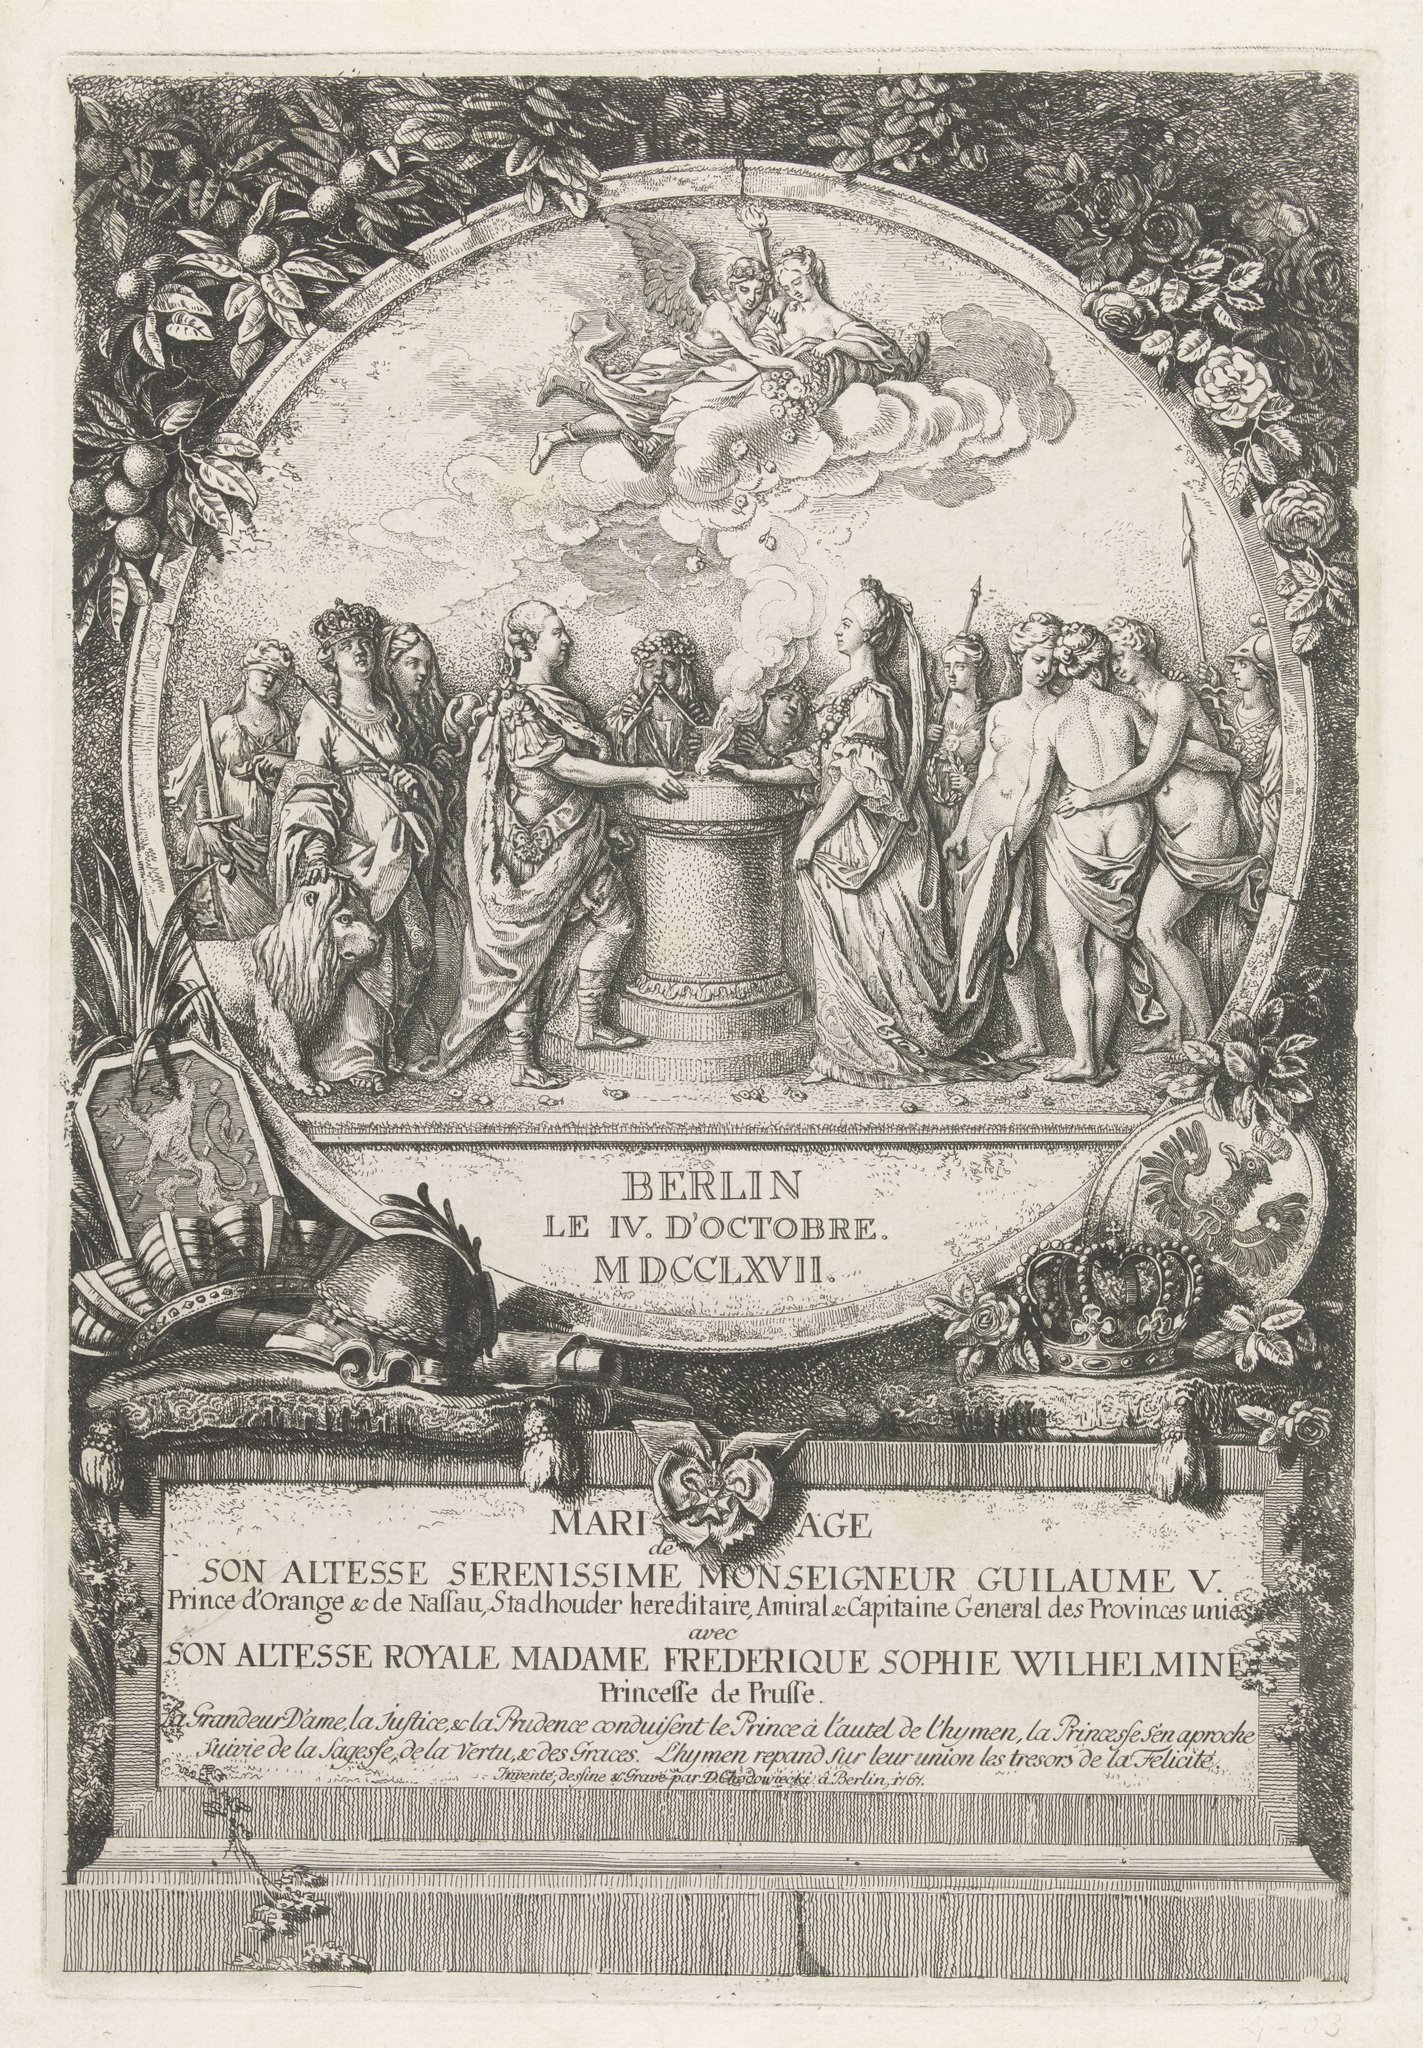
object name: print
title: Mariage de Son Altesse Serenissime Monseigneur Guilaume V. Prince d'Orange & de Nassau (...) avec Son Altesse Royale Madame Frederique Sophie Wilhelmine Princesse de Prusse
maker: daniel nikolaus chodowiecki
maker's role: draughtsman, print maker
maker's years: 1726-1801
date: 1767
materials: paper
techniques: etching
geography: berlin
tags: the hague, william v (prince of orange), painter, draughtsman, wilhelmina of prussia (princess of orange), (civil) marriage ceremonies (+ variant)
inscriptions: collector's mark: Lugt 2166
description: Allegorie op het huwelijk van stadhouder Willem V en prinses Wilhelmina van Pruisen op 4 oktober 1767 te Berlijn. Medaillon met de prins en prinses voor het huwelijksaltaar, begeleid door allegorische figuren. Op het voetstuk symbolen van hun vorstendom.